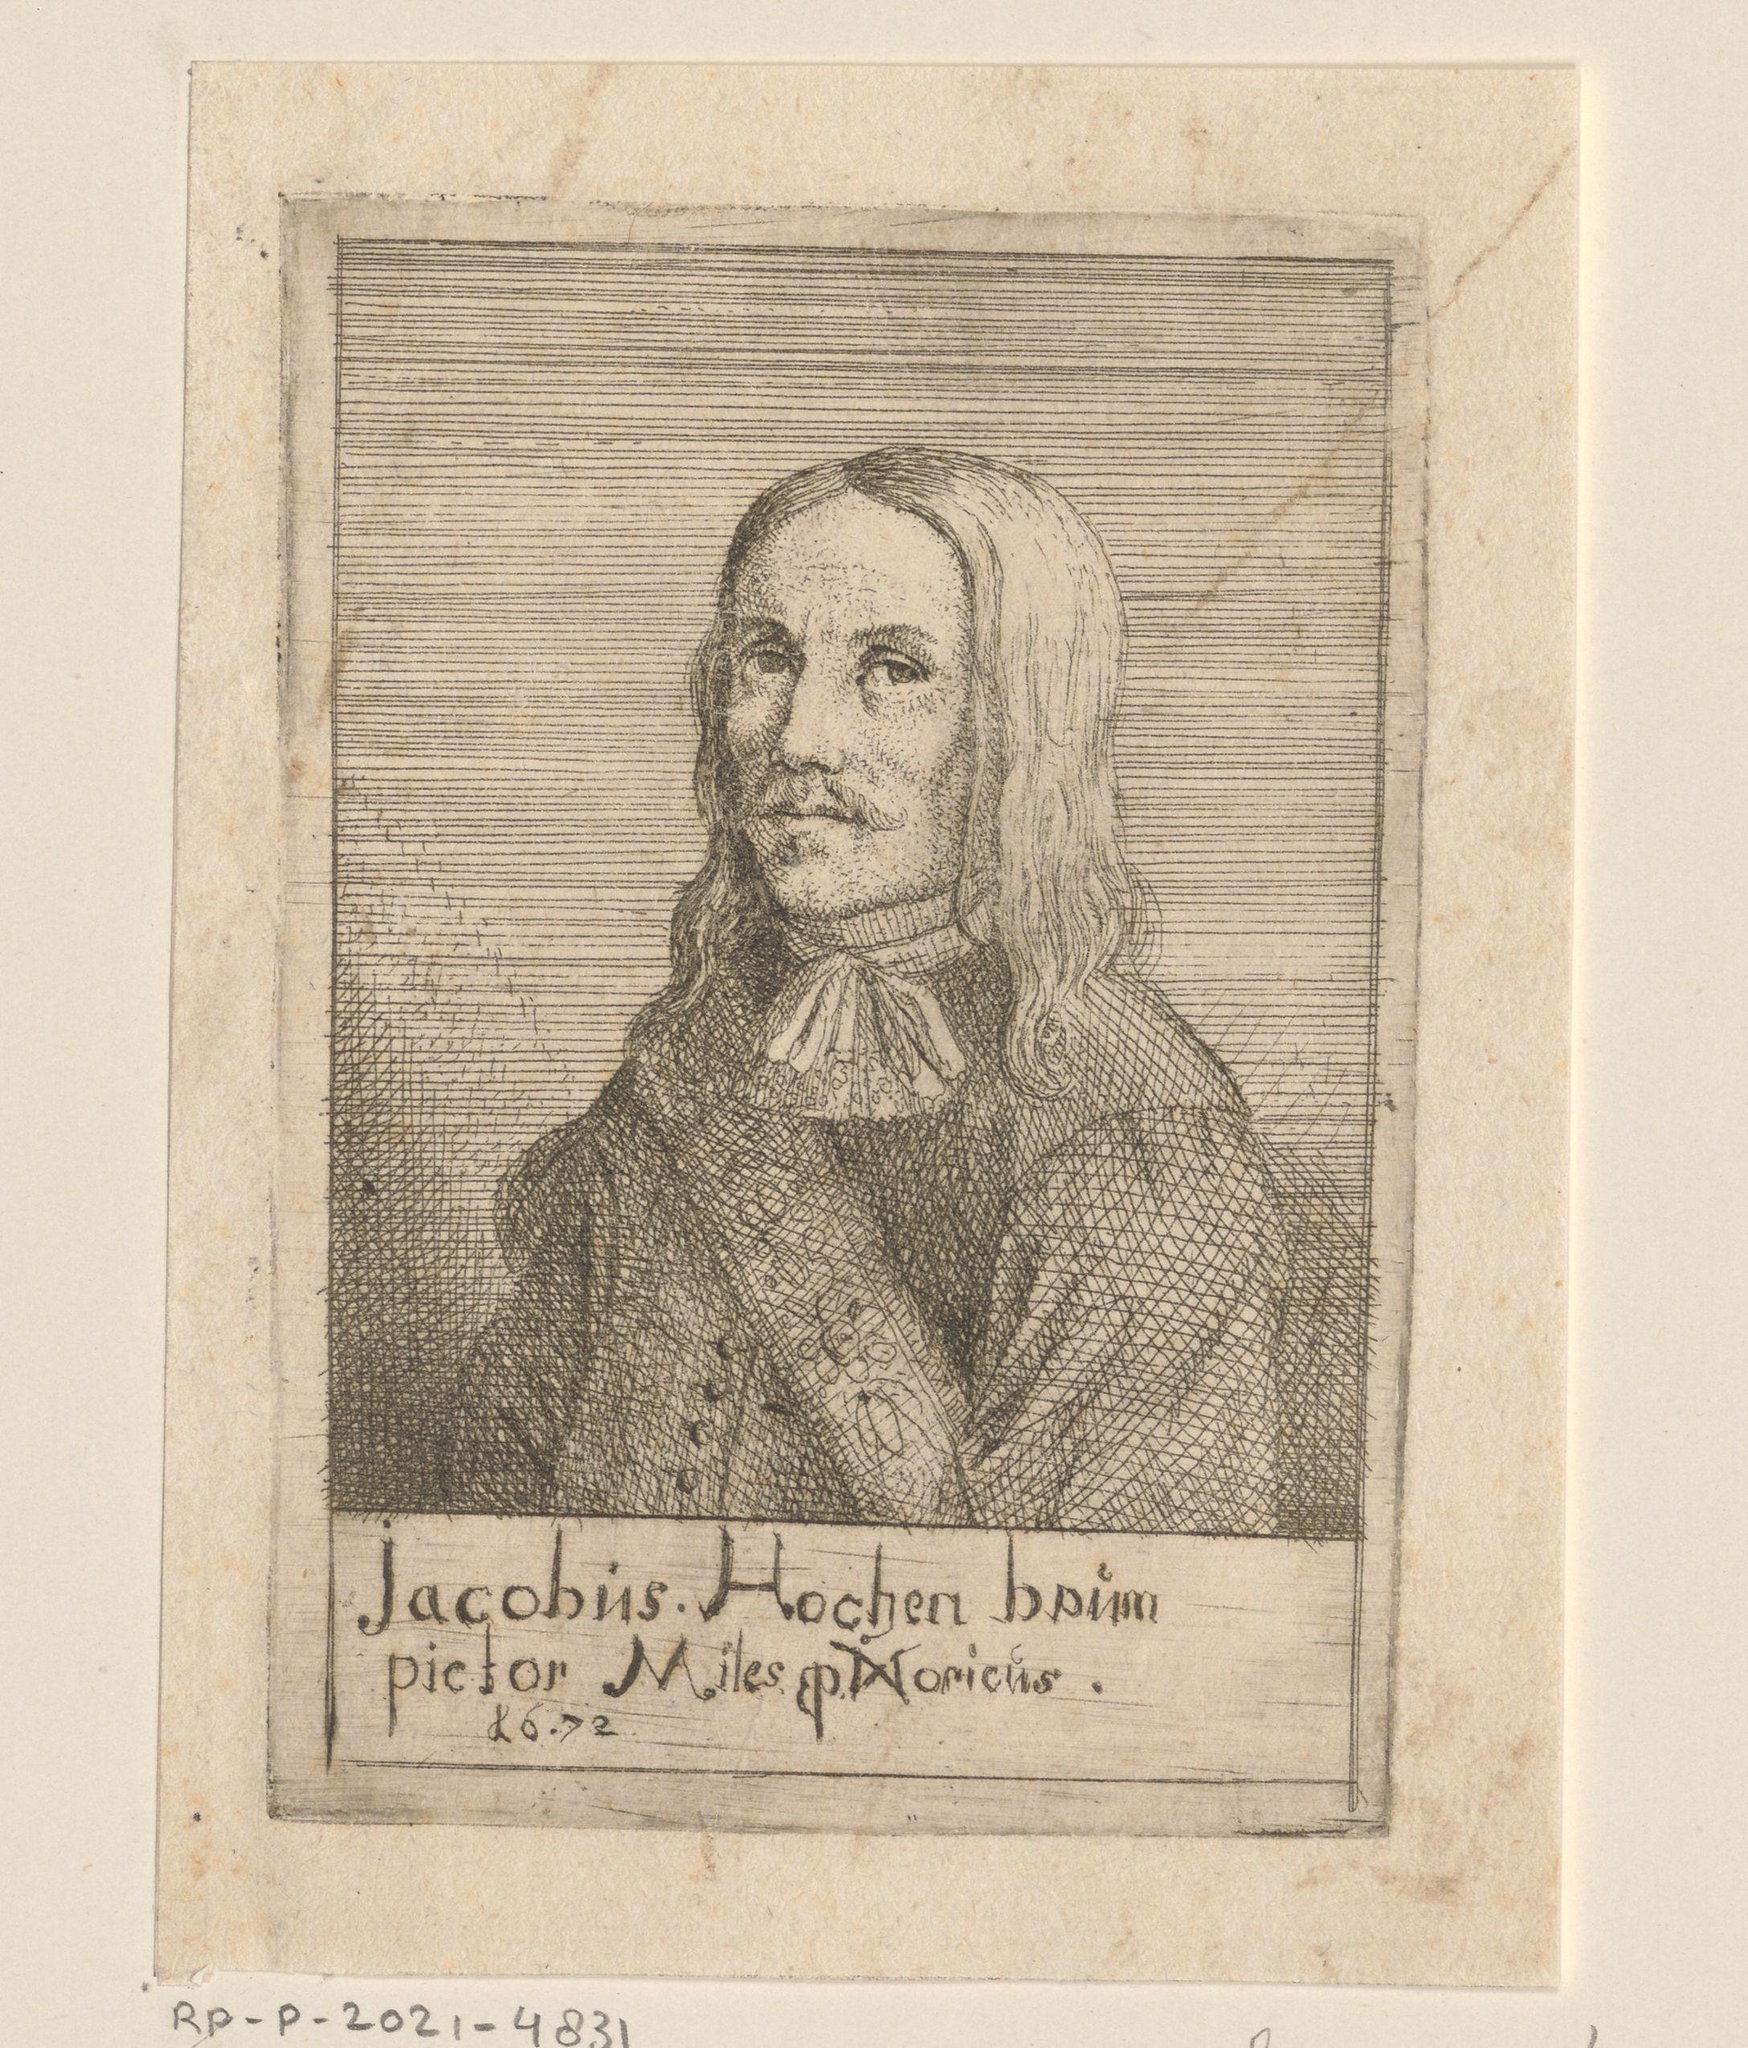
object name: print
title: Portret van Jacob Hochenbaum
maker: johann franz ermels (der ältere)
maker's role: draughtsman, print maker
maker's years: 1641-1693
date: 1672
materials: paper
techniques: etching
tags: painter, historical persons, portrait, self-portrait of painter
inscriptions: date